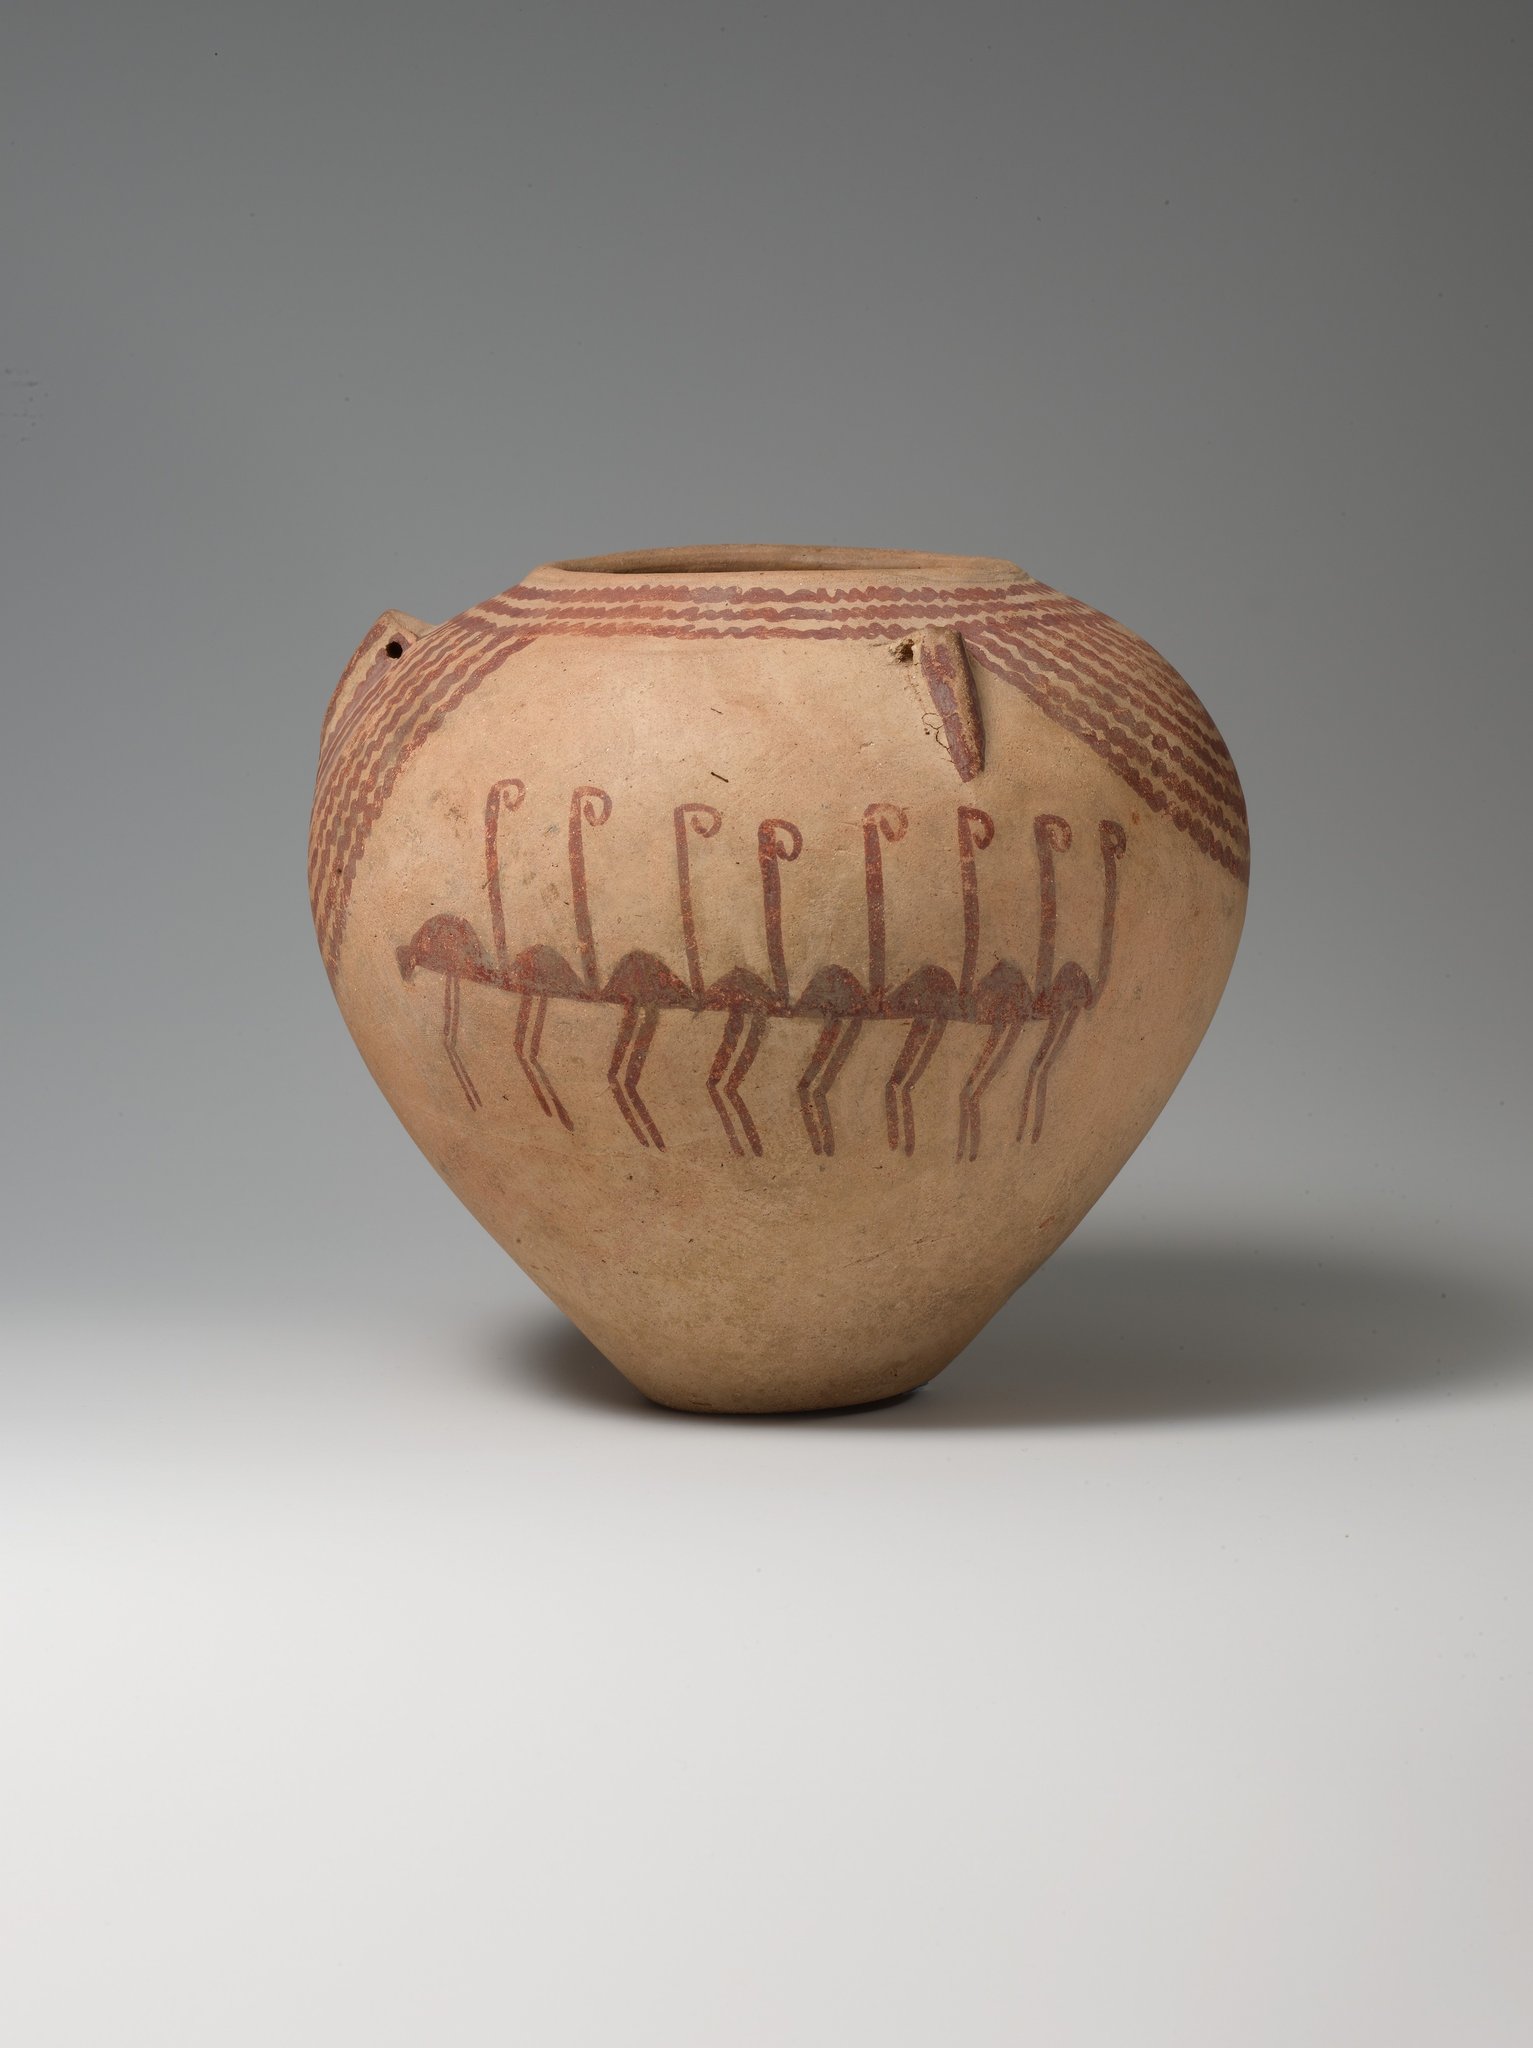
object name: jar, decorated ware, flamingo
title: Decoratred ware jar depicting rows of flamingos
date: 3650-3300 BCE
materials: paint, pottery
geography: egypt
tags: birds